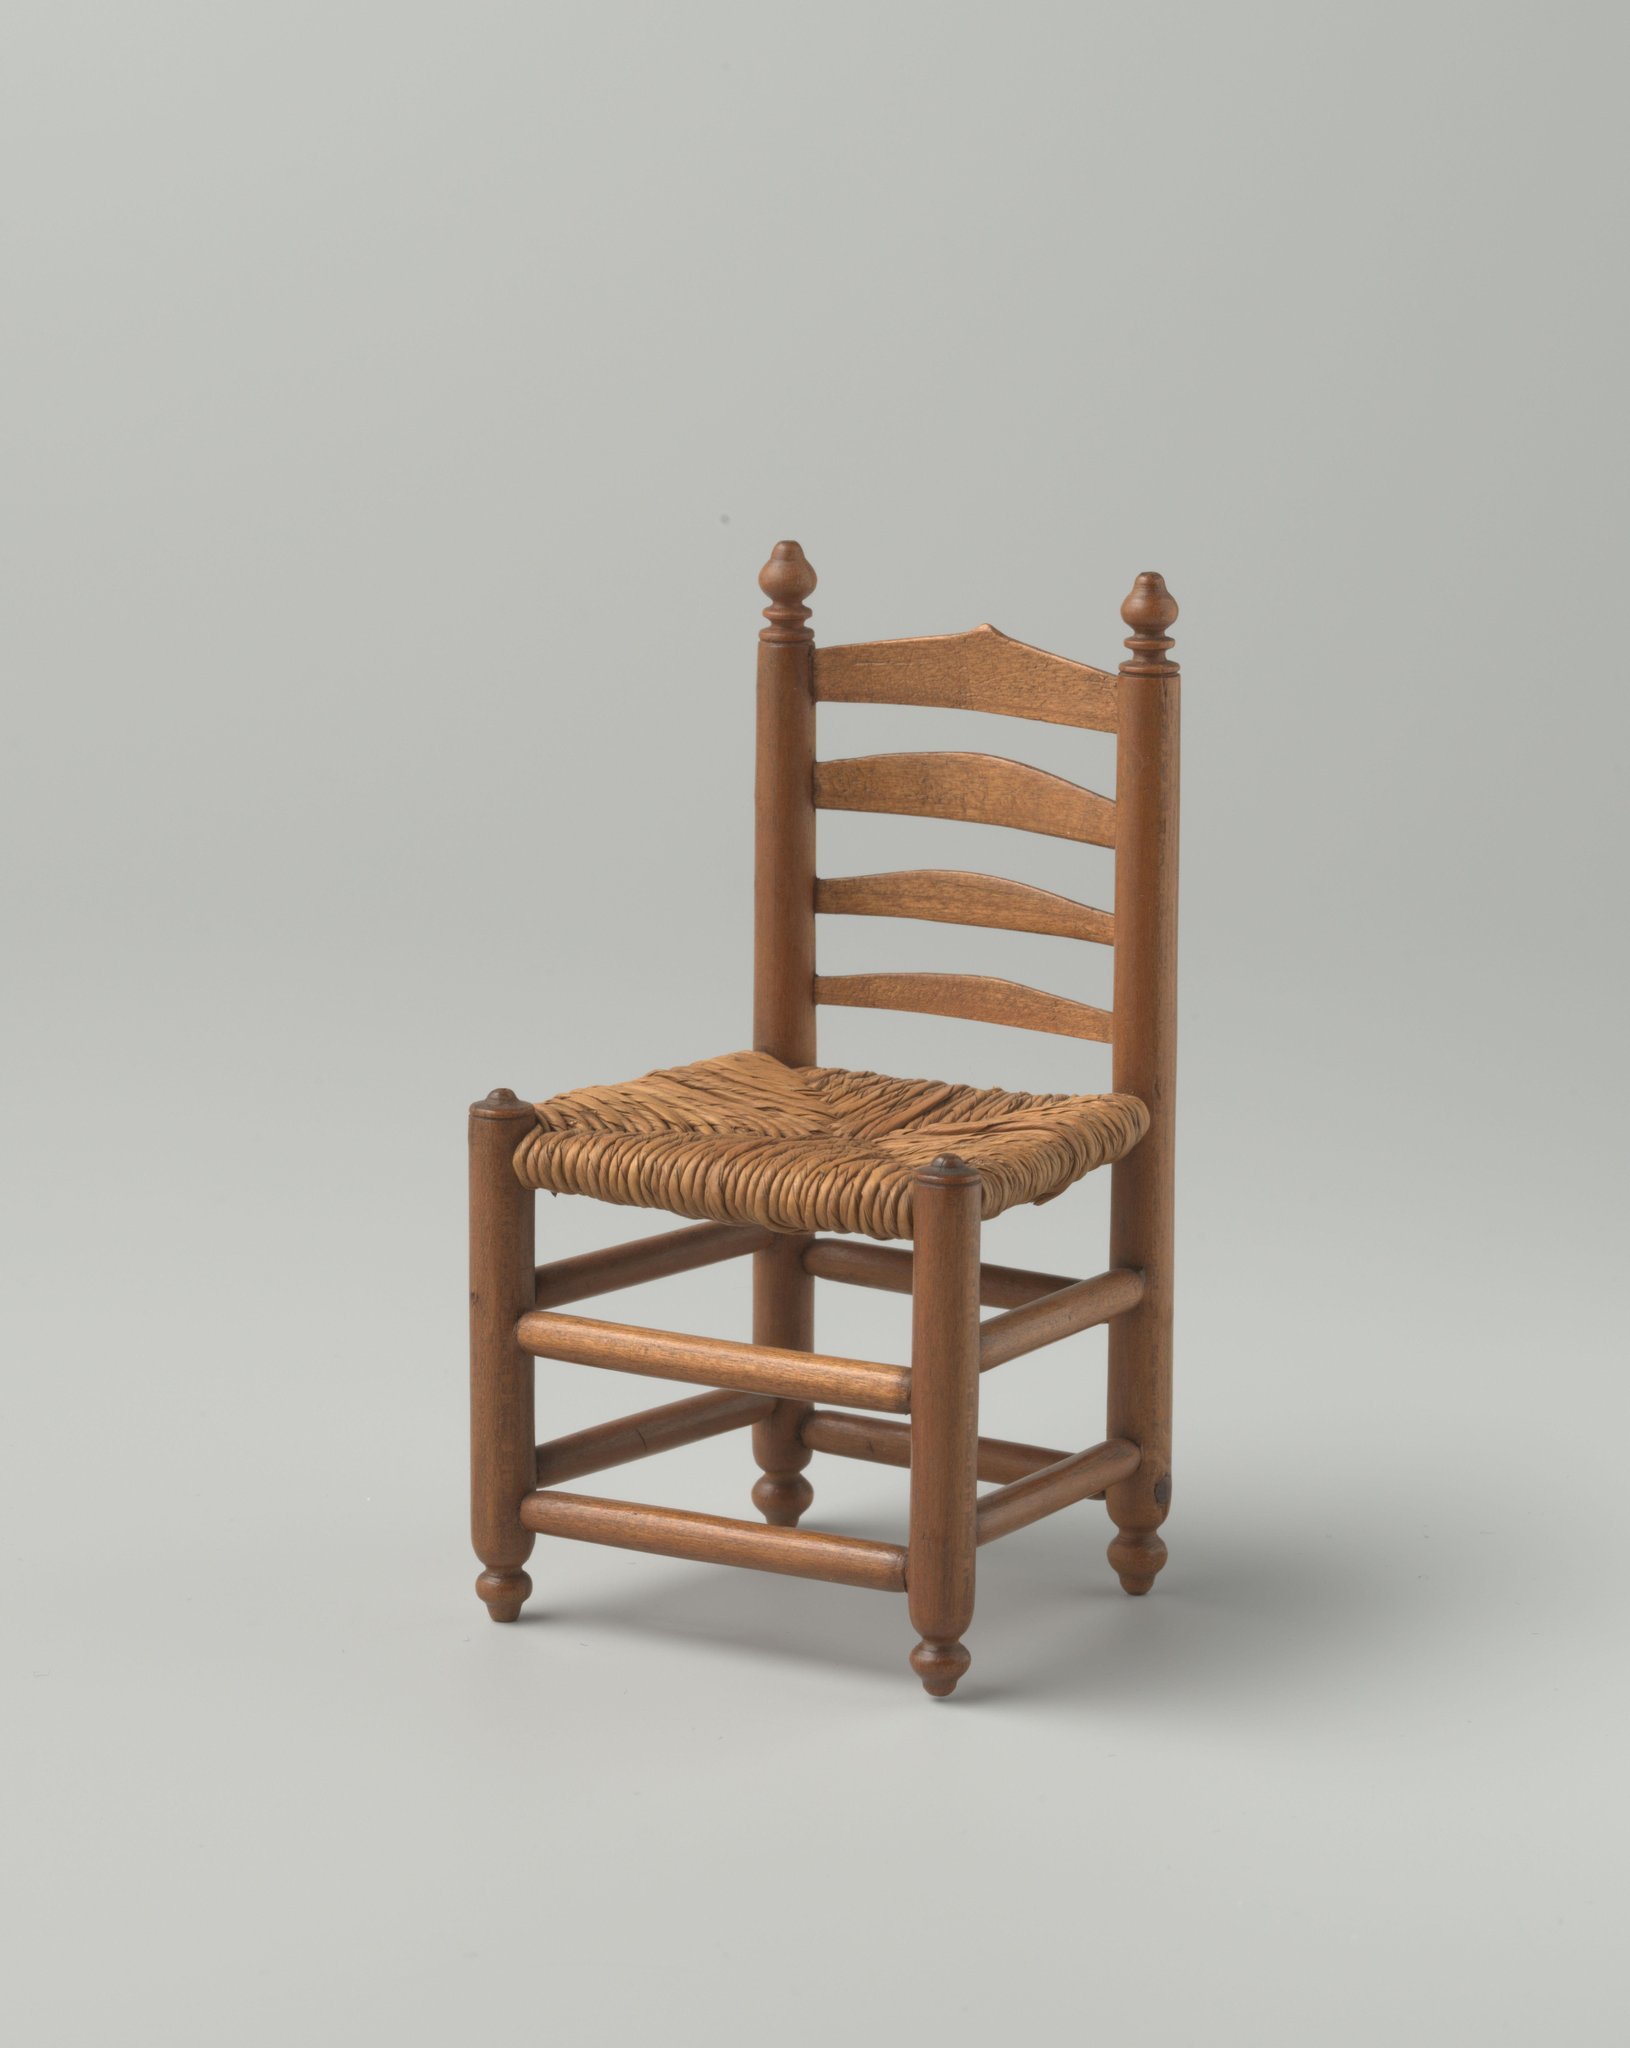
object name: chair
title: Knopstoel vervaardigd van esdoornhout met gladde, gedraaide stijlen en dwarsregels, voorpoten en achterstijlen eindid in fijn gedraaide knoppen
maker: Anonymous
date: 1690-1710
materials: wood, fiber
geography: amsterdam